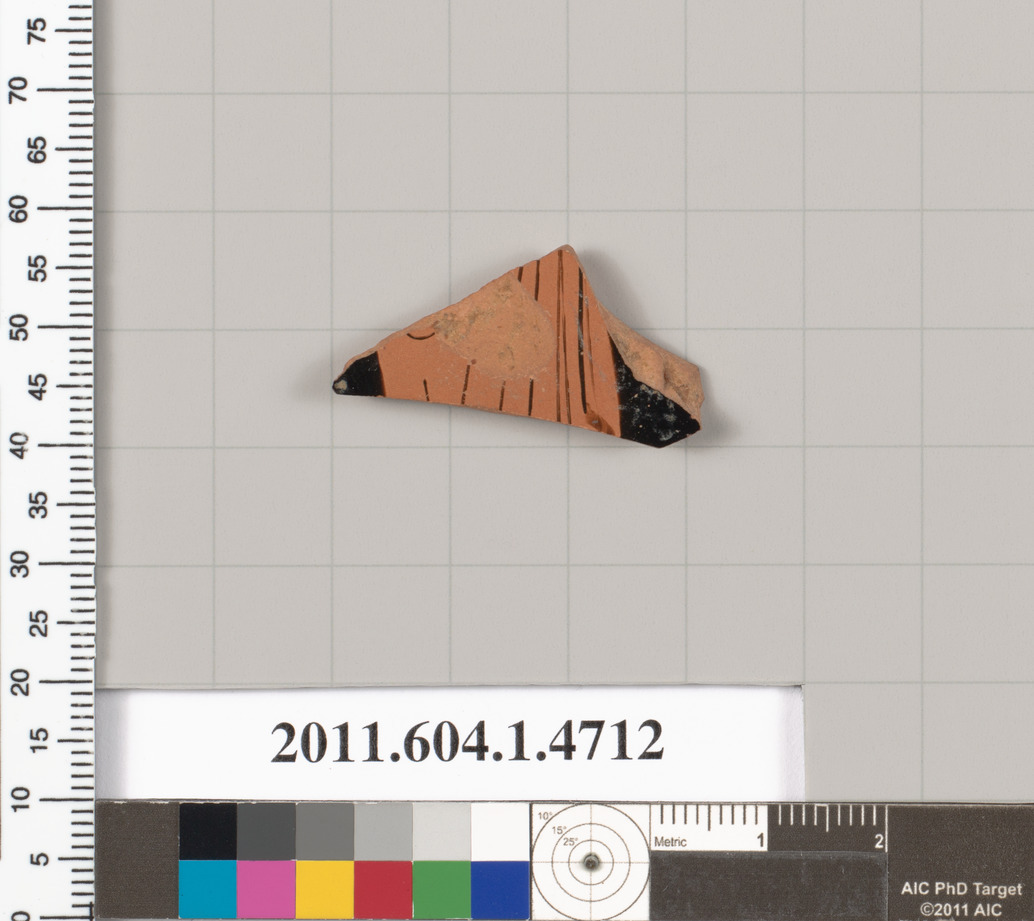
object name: kylix fragment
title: Terracotta fragment of a kylix (drinking cup)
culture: greek, attic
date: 475-451 BCE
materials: terracotta